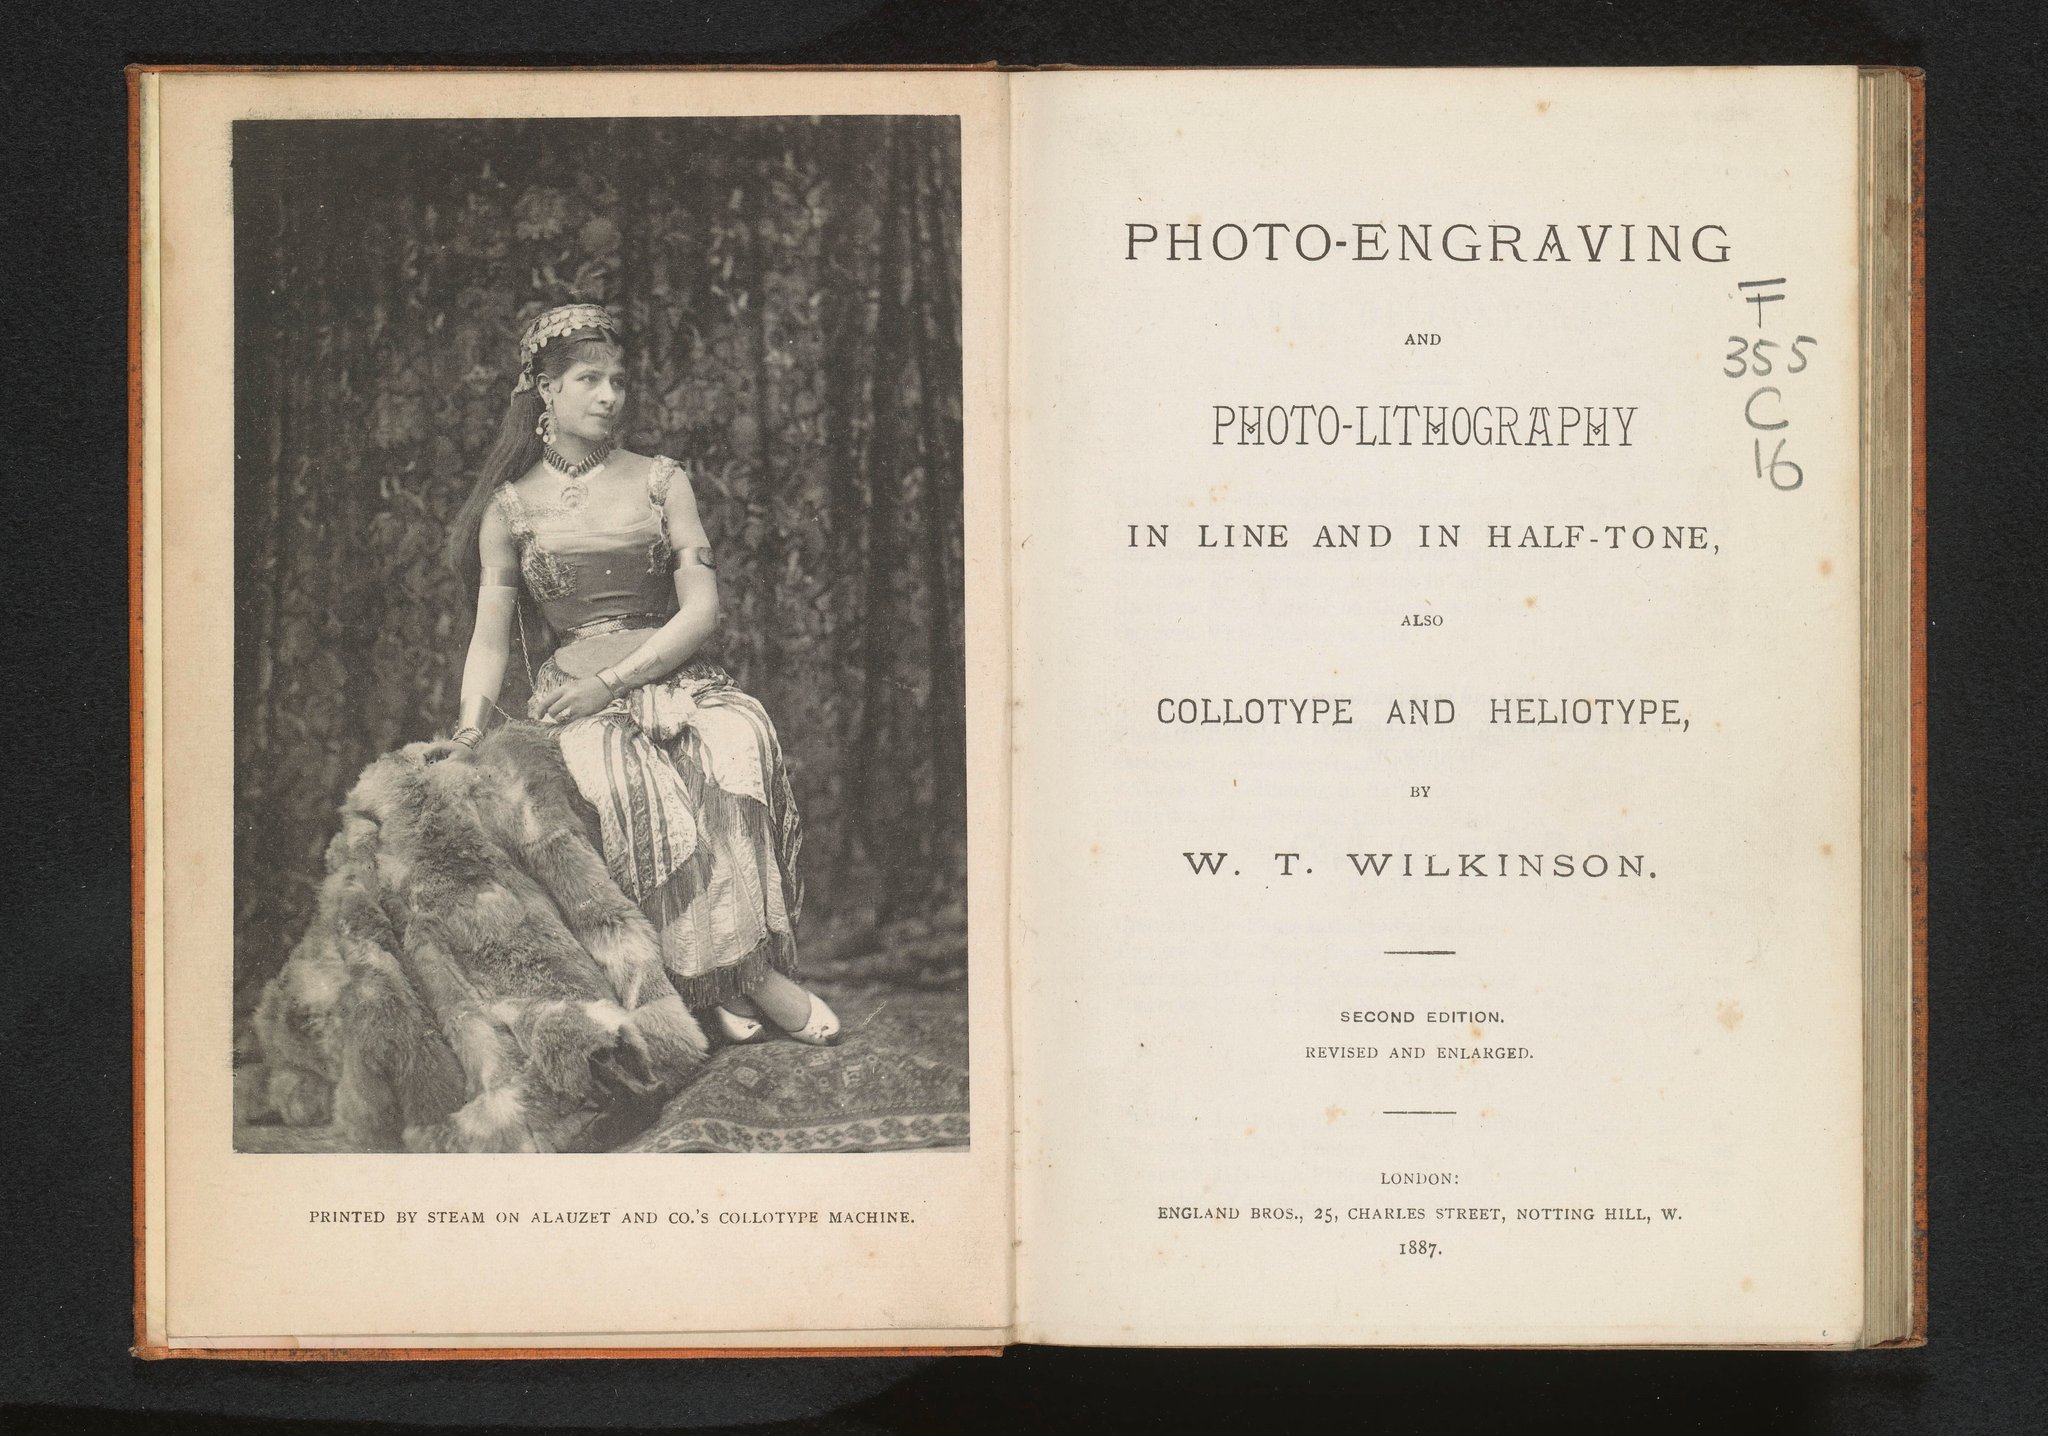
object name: photomechanical print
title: Studioportret van een onbekende actrice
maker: Anonymous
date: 1877-1887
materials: paper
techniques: photograph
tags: studio ~ photographer, portrait of actor, actress